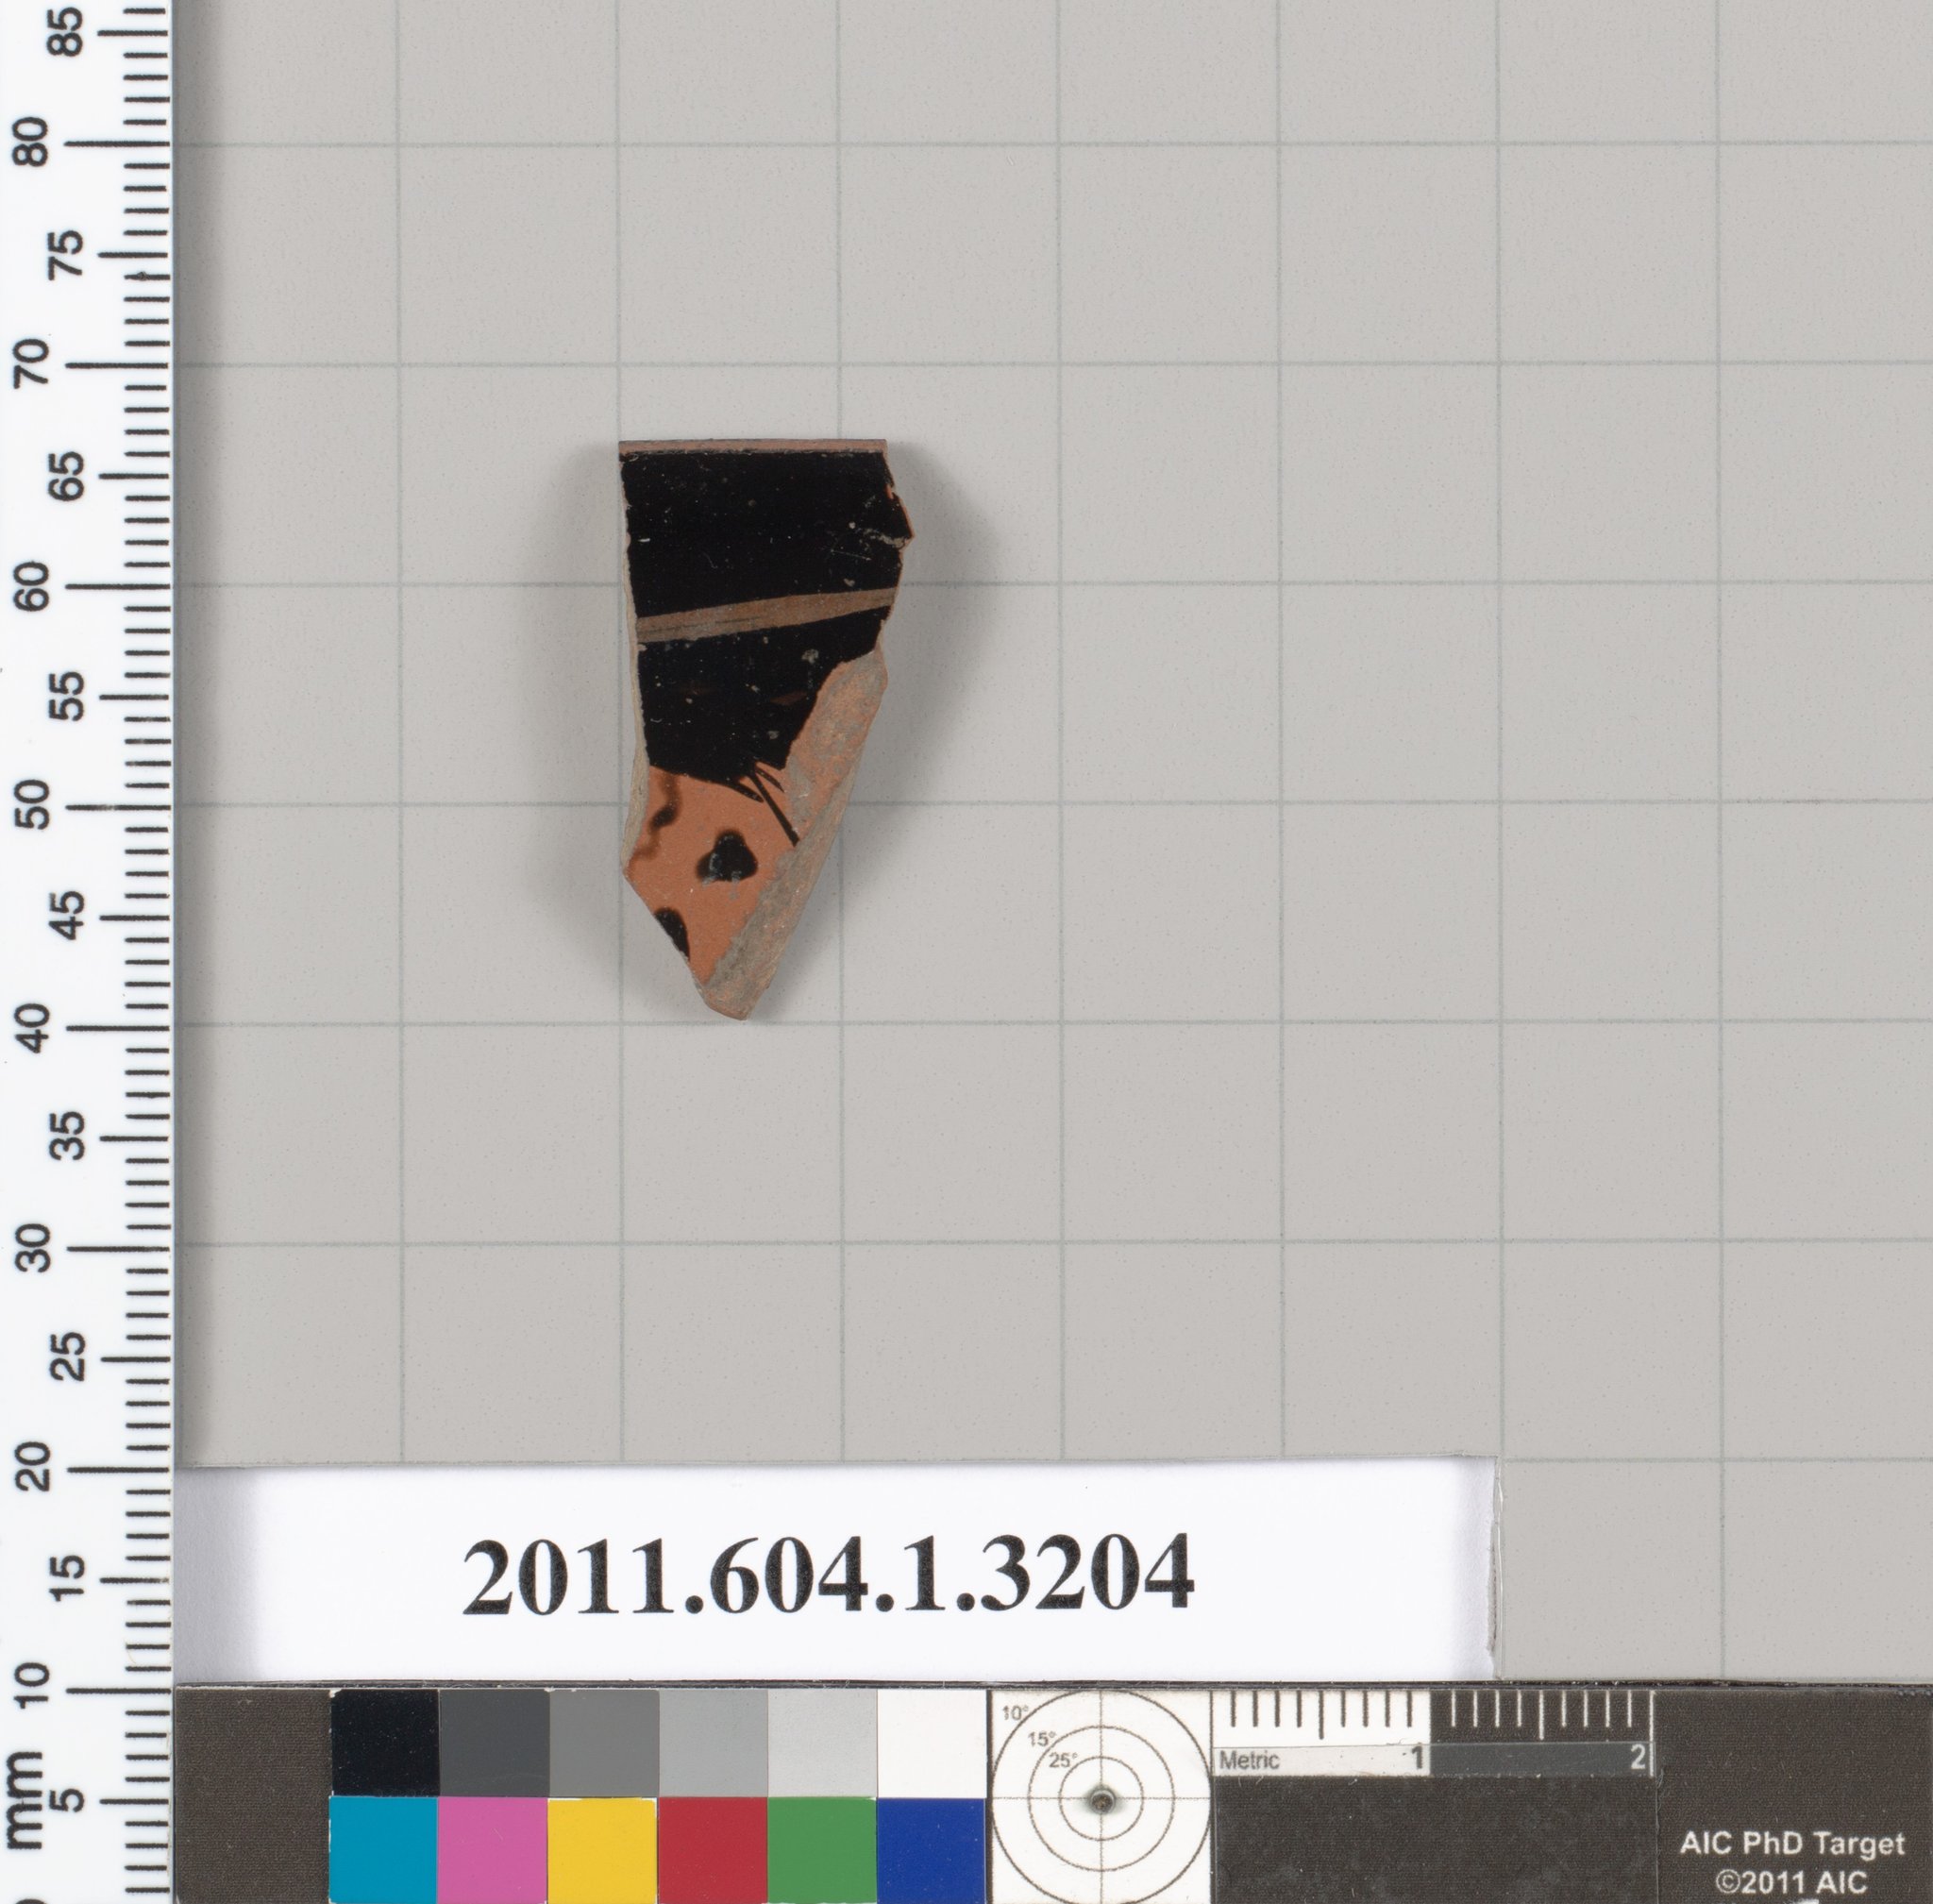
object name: kylix fragment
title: Terracotta rim fragment of a kylix (drinking cup)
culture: greek, attic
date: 500-476 BCE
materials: terracotta